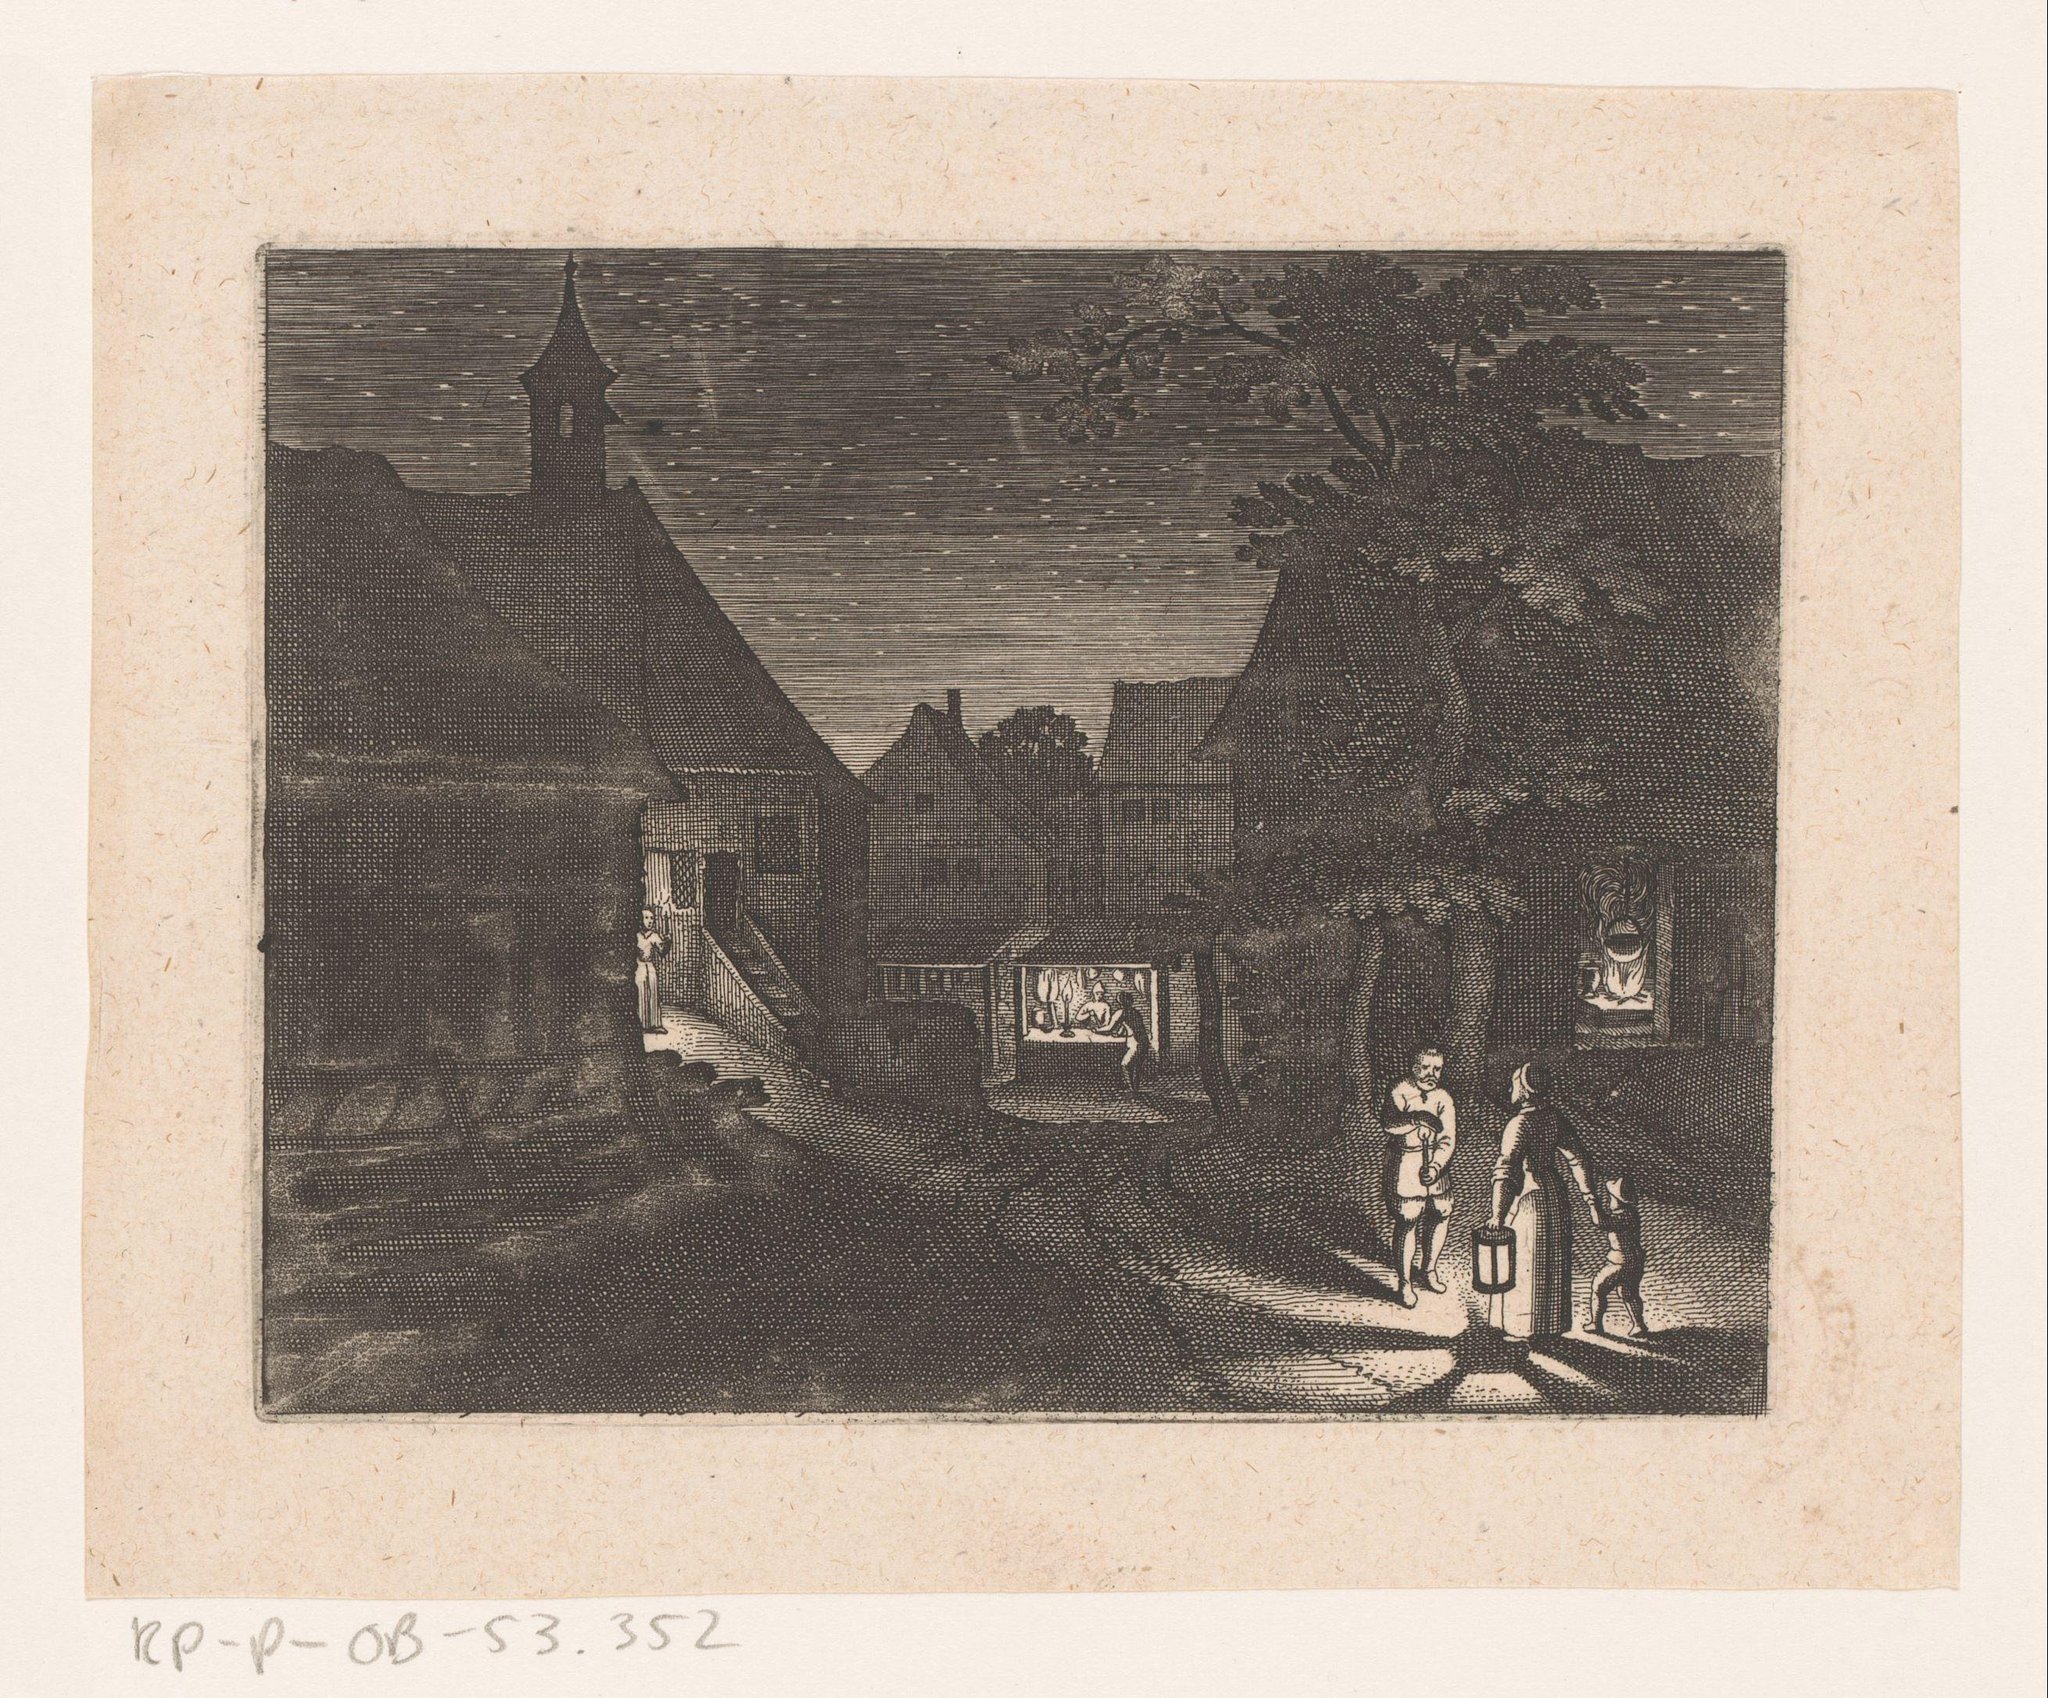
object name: print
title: Dorp bij nacht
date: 1603-1645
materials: paper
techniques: etching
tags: village, night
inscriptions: collector's mark: Lugt 1838, collector's mark: Lugt 240